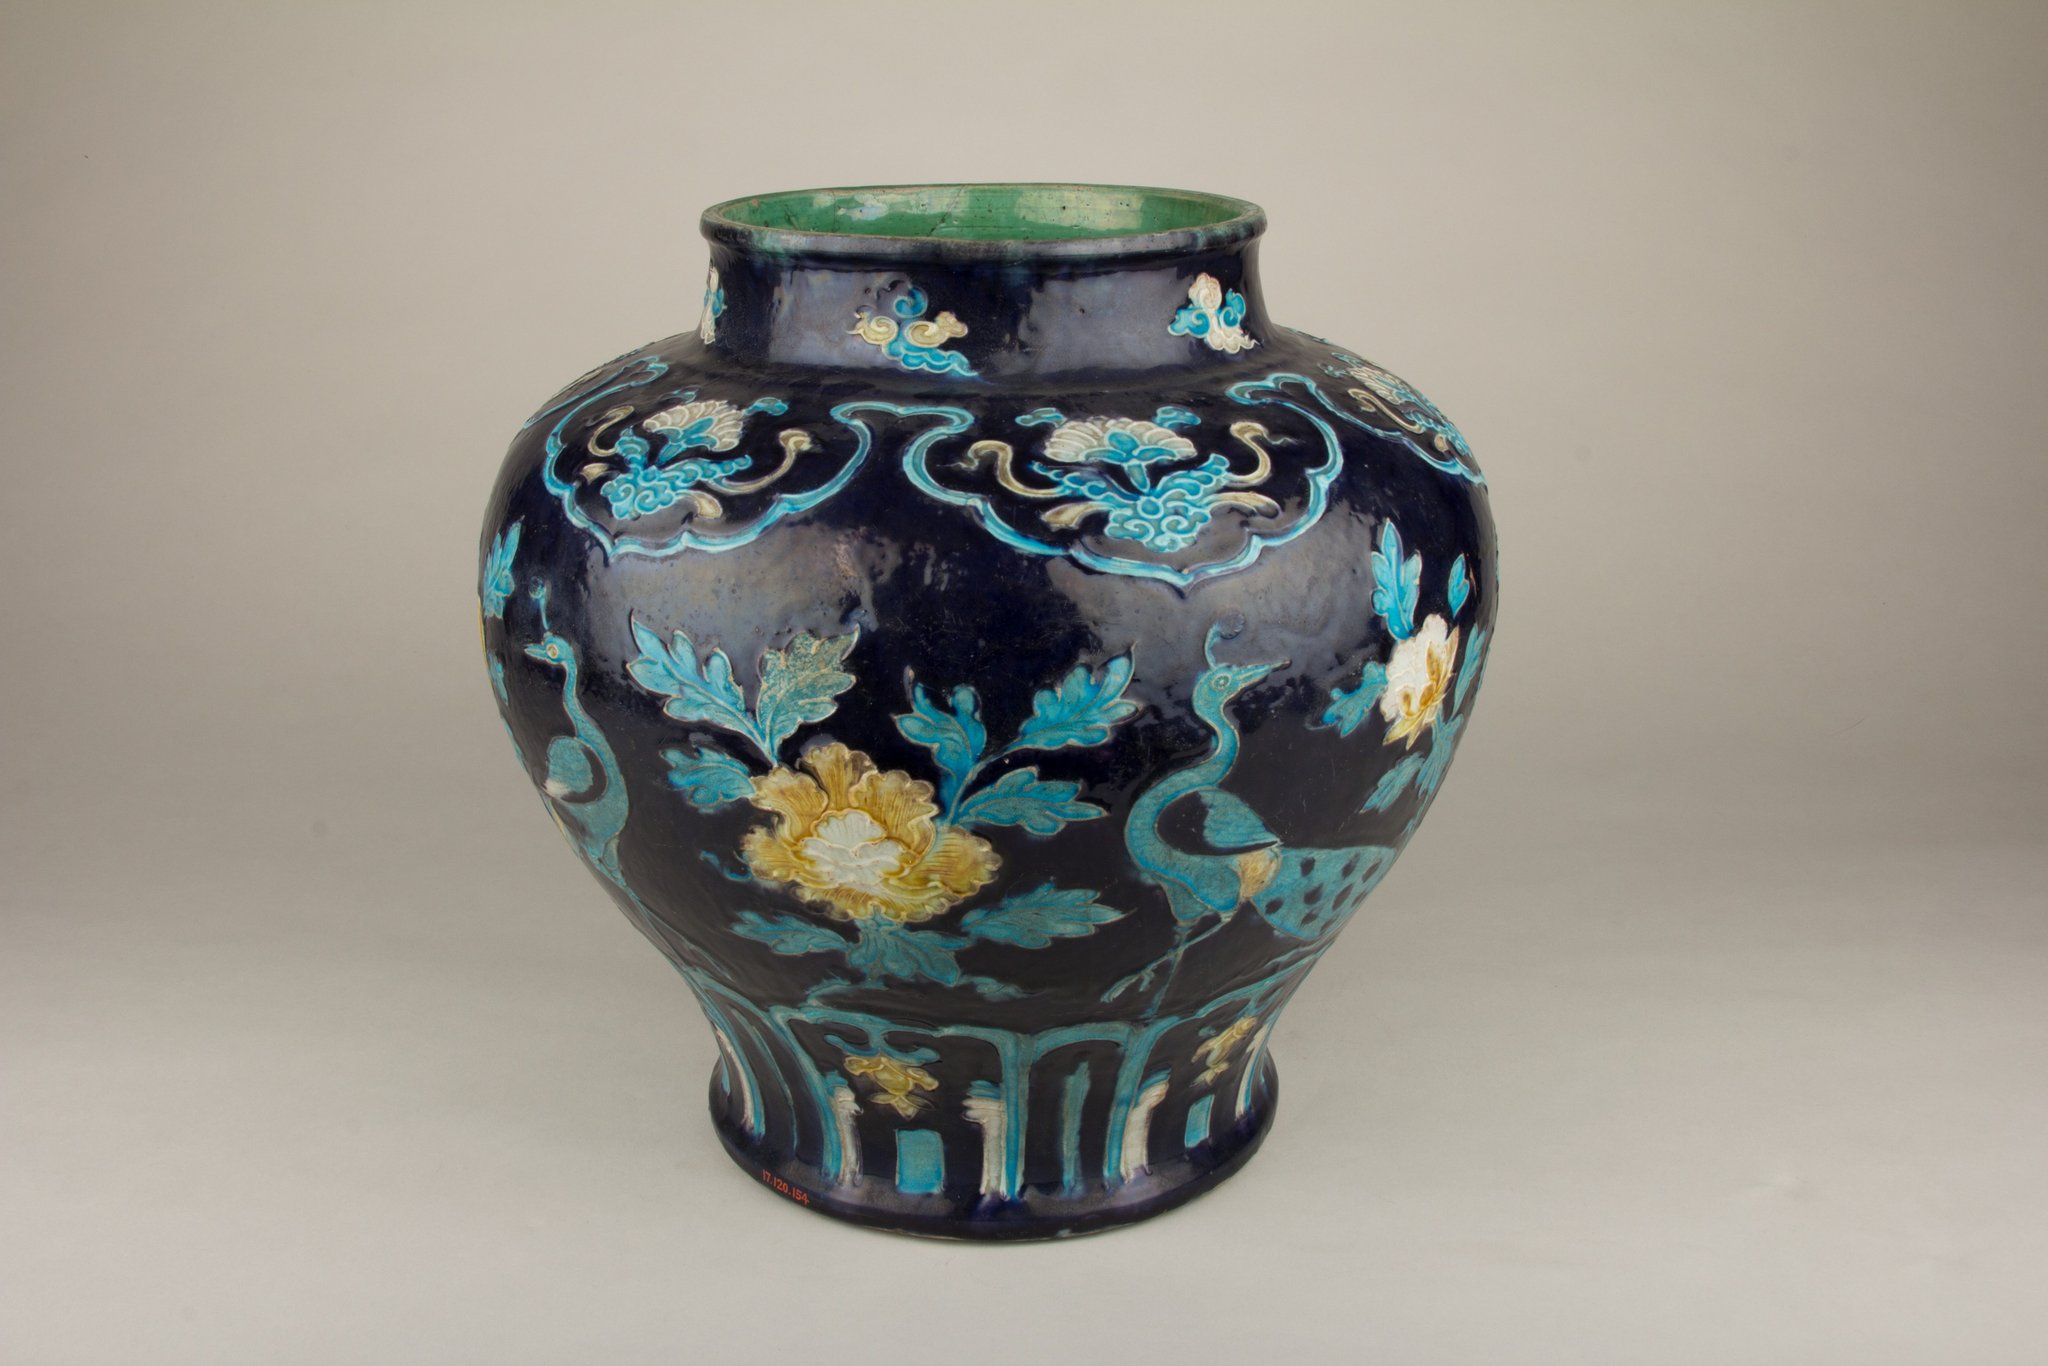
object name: jar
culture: chinese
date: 1368-1644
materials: pottery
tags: peacocks,flowers,leaves